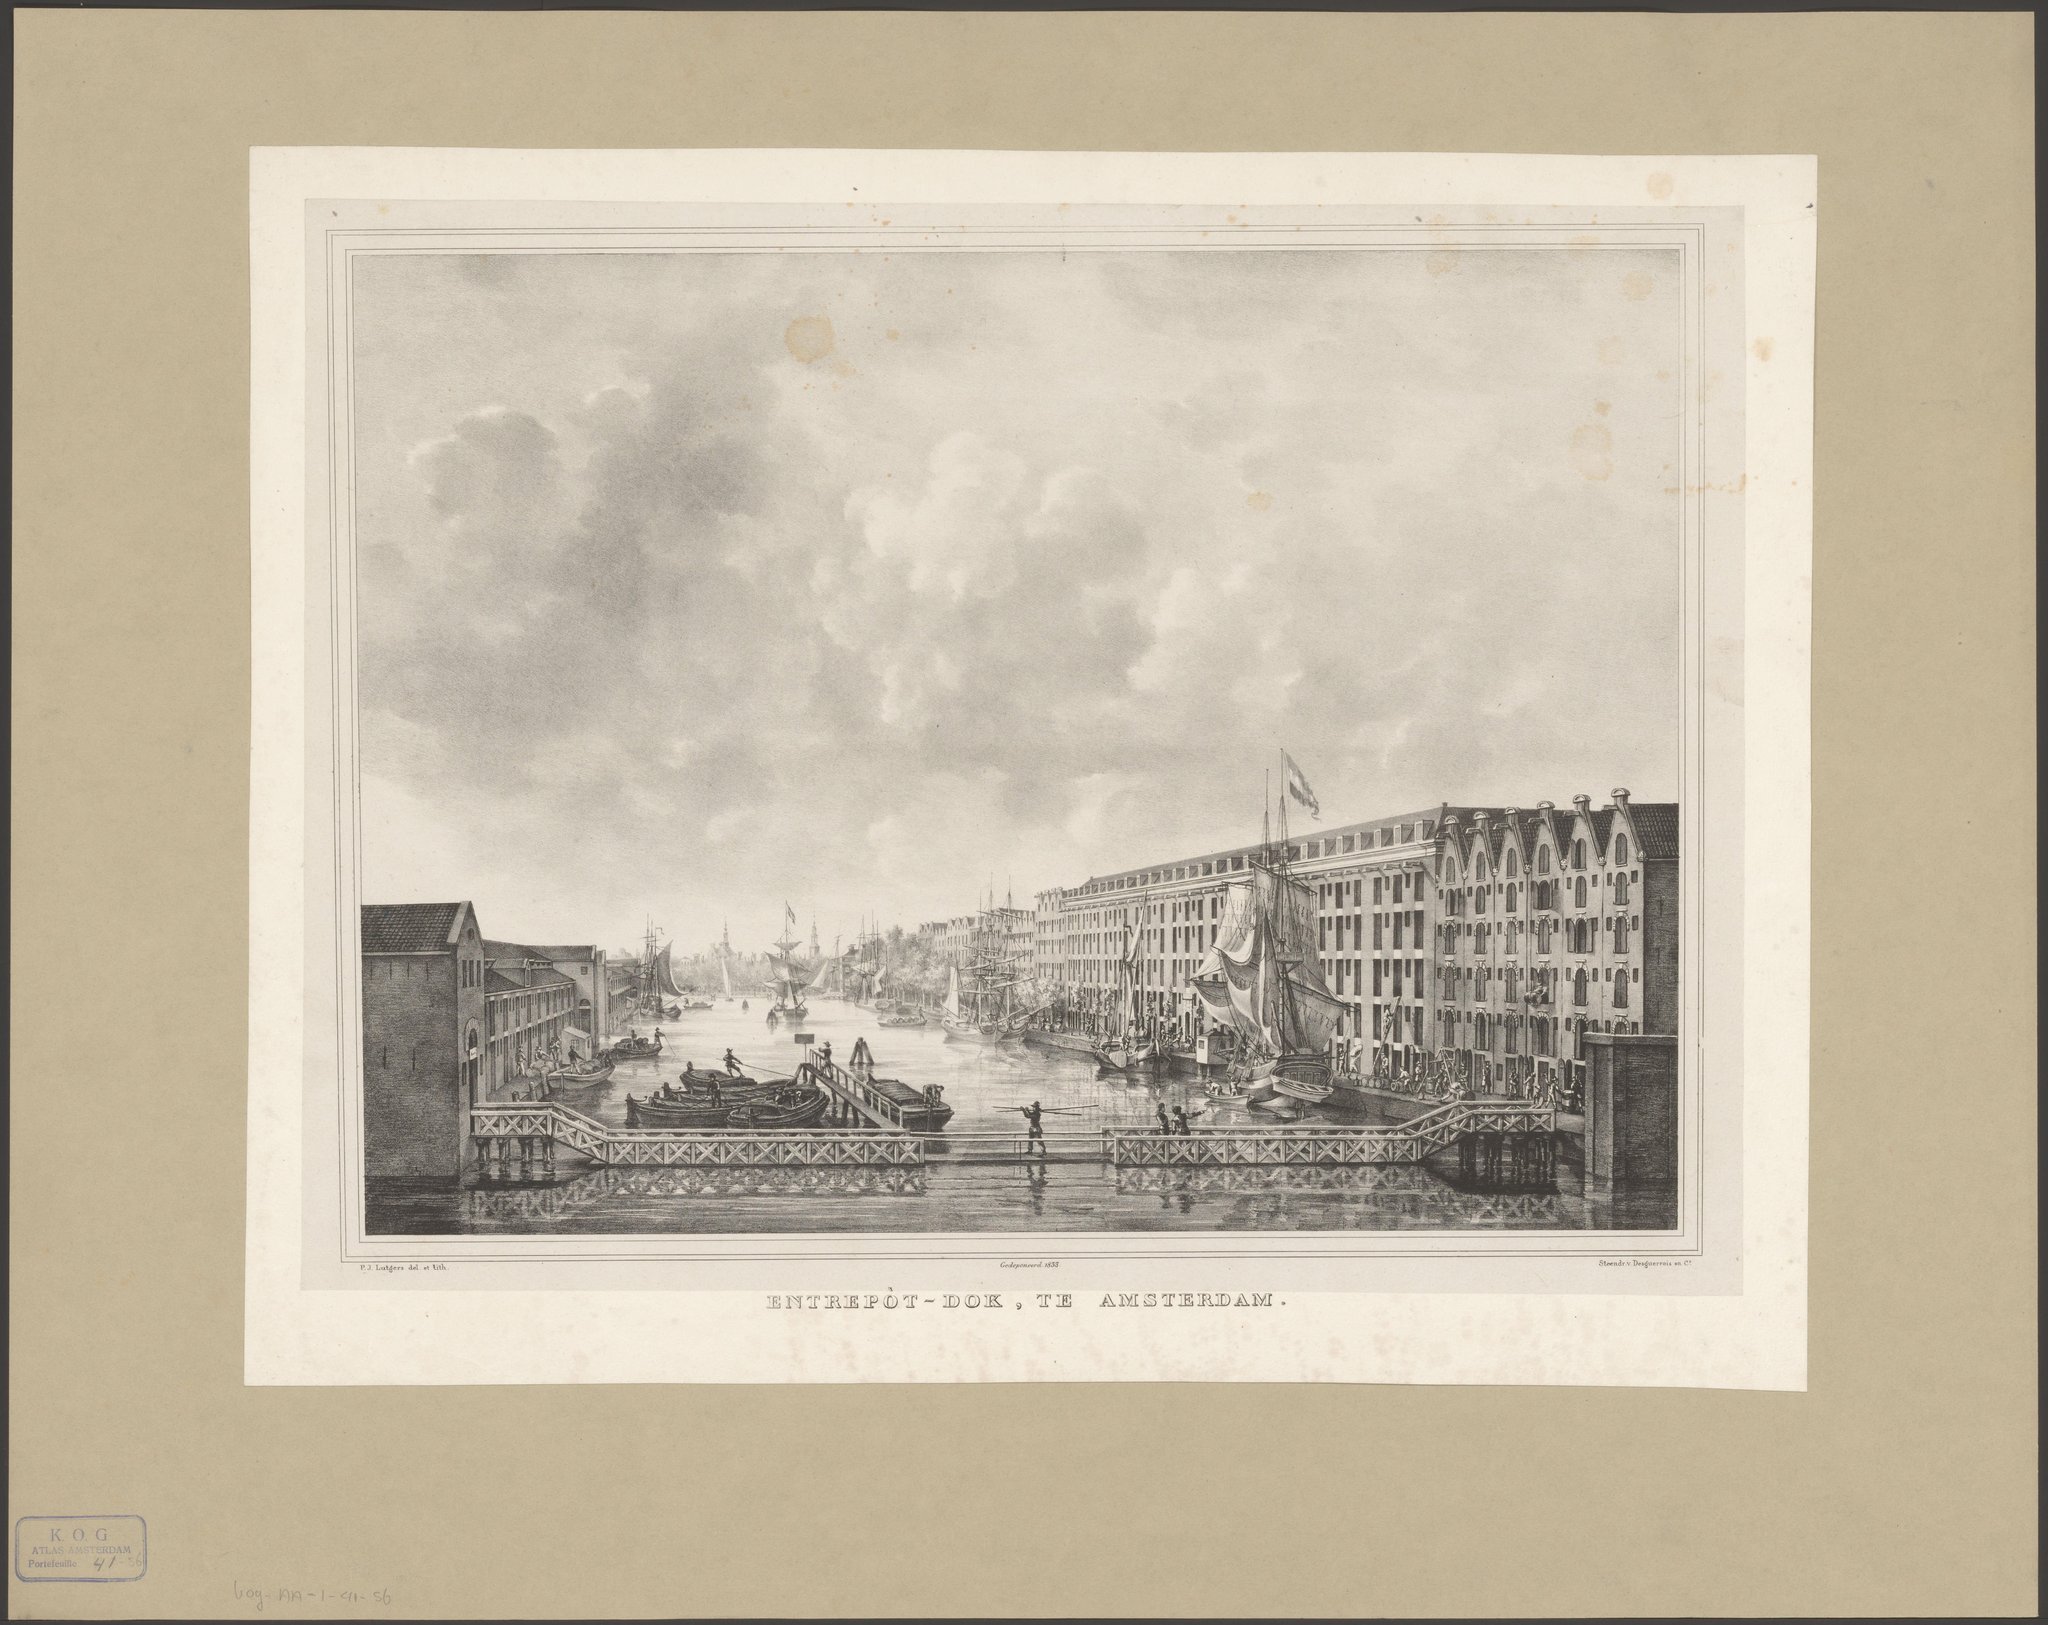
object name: print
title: Gezicht op het Entrepotdok te Amsterdam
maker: petrus josephus lutgers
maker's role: draughtsman, print maker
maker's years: 1808-1874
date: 1833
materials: paper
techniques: lithograph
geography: amsterdam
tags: dry-dock, floating-dock - cc - more than one ship, canals, waters (in city), bridge in city across river, canal, etc., merchant shipping, shipping trade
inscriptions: : ‘Gedeponeerd.’, collector's mark: ‘41-56’ Lugt 1641b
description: Onderwerpsrubriek binnen de Atlas Amsterdam: Entrepot.